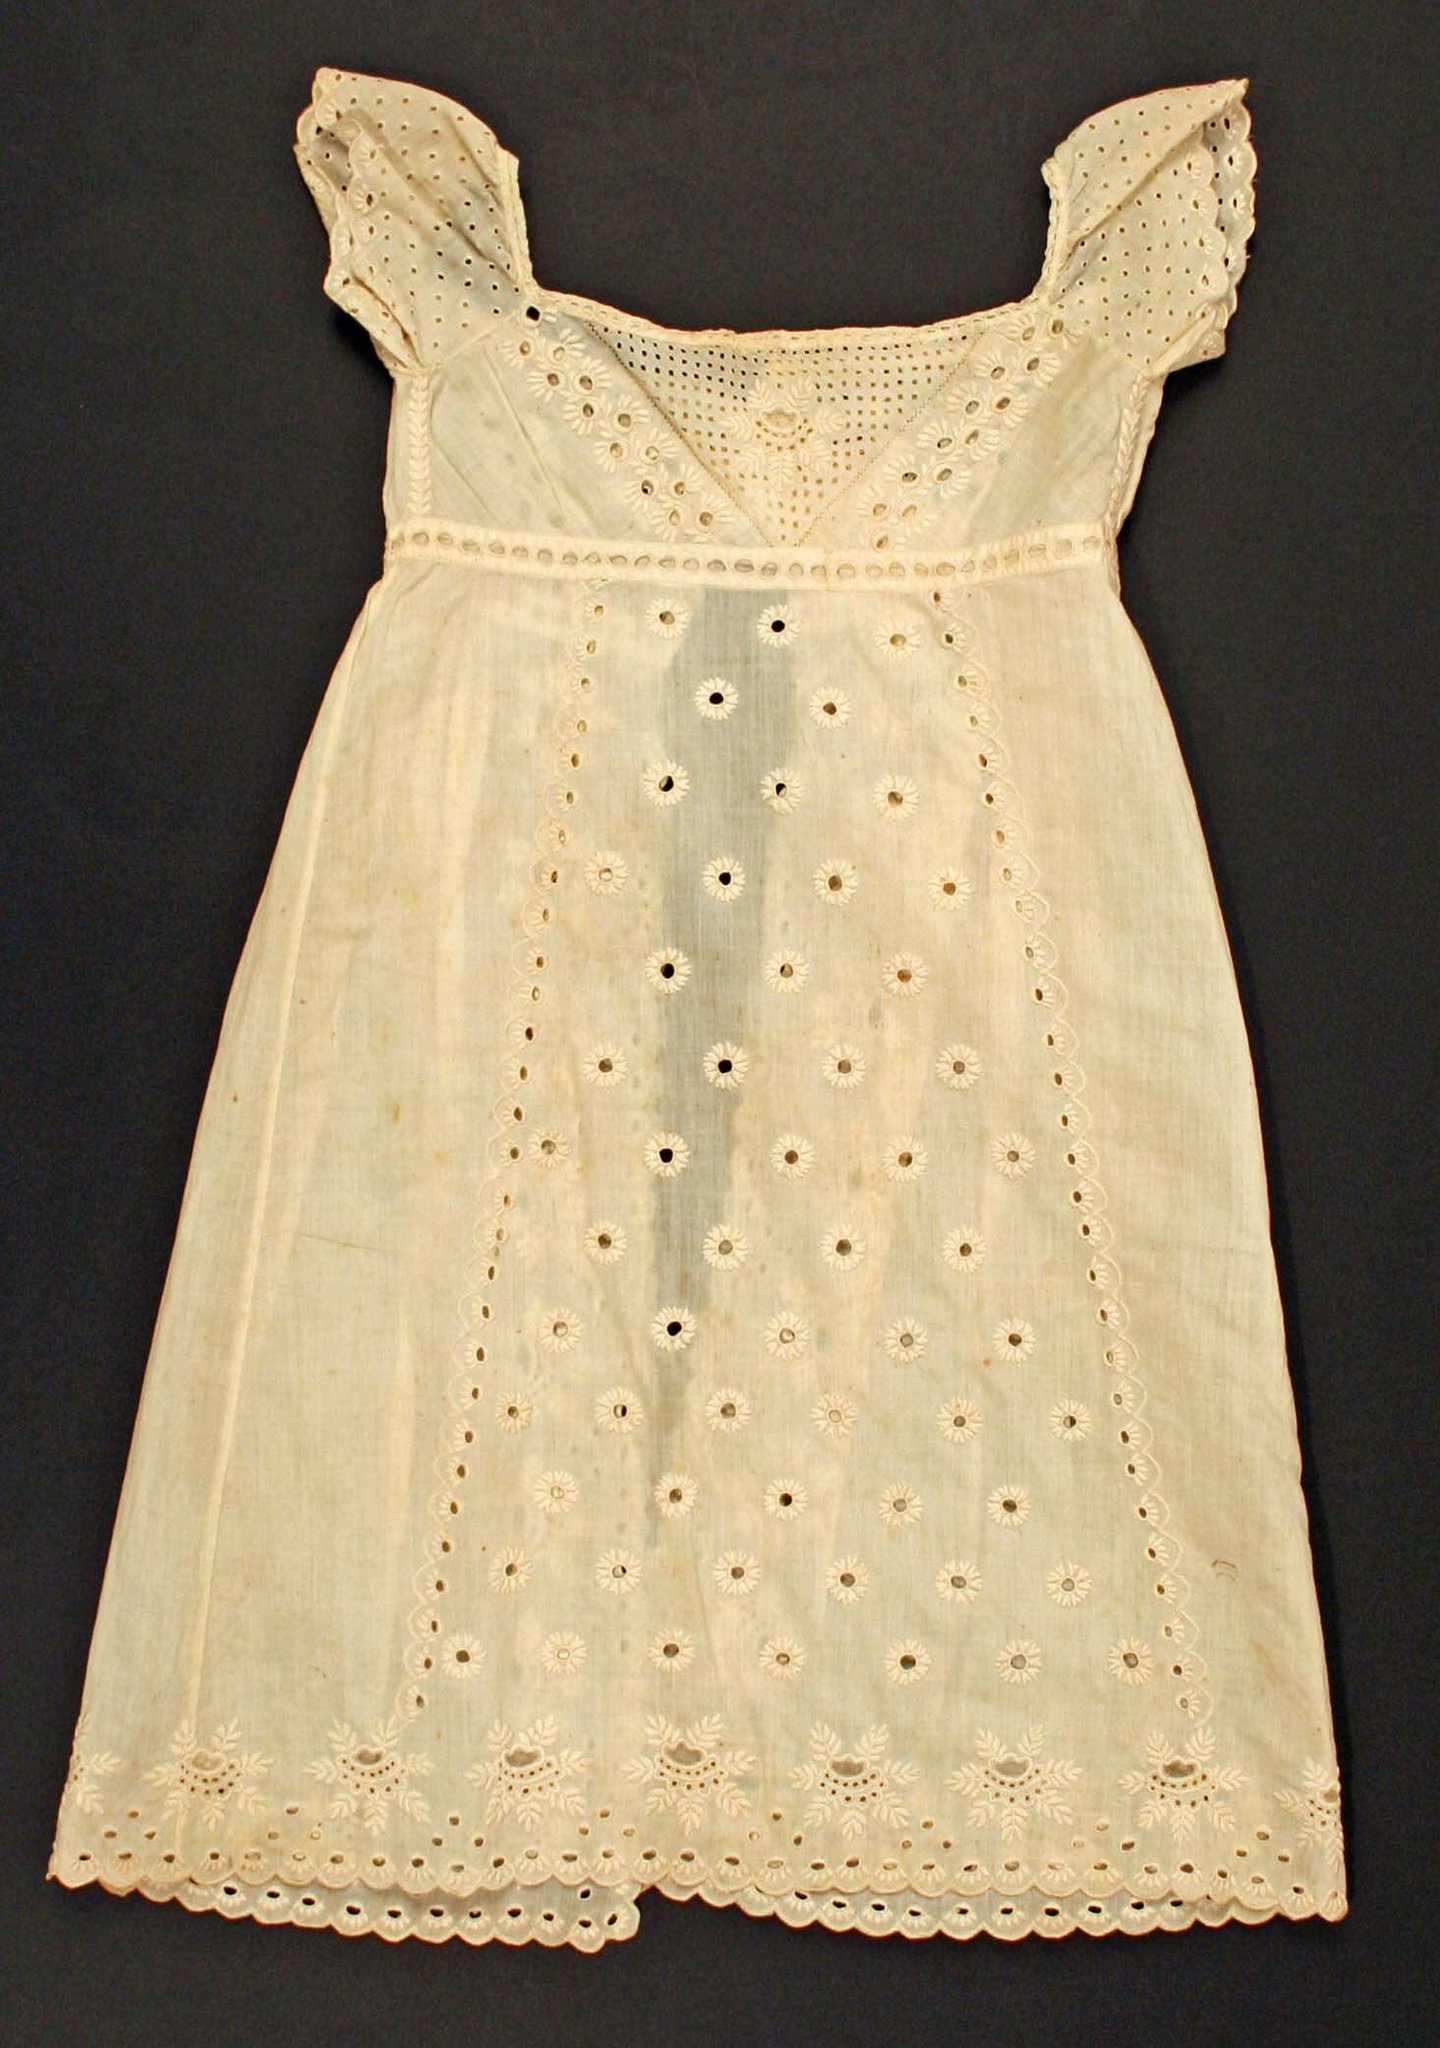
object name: pinafore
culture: american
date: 1801-1833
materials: cotton